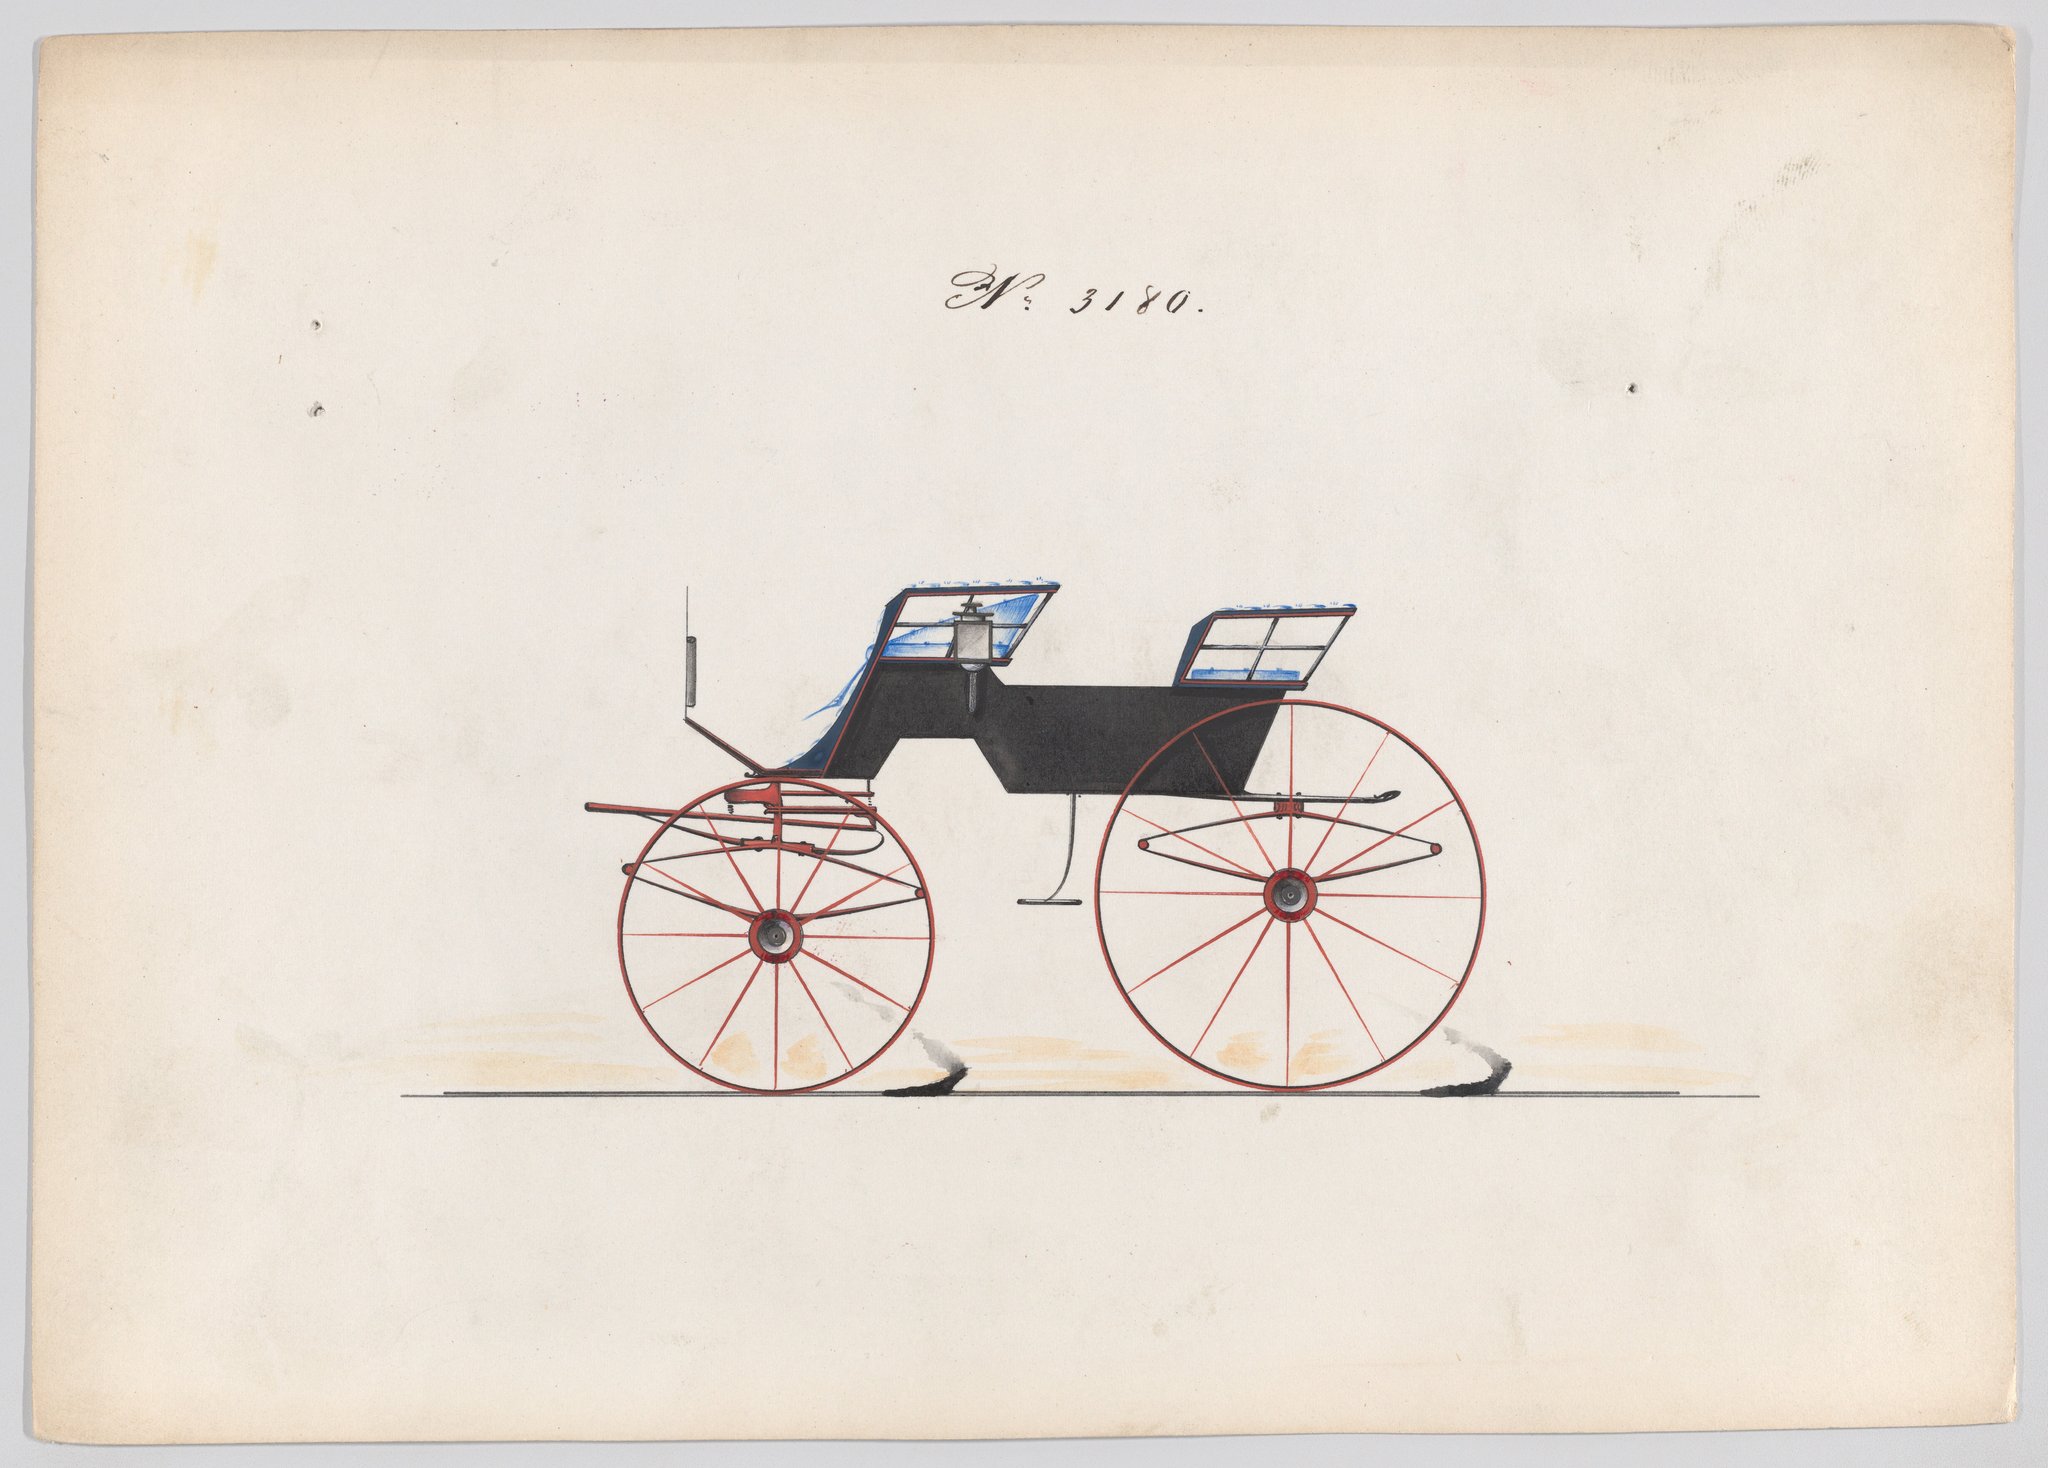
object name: drawing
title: Design for T-Cart, no. 3180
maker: brewster & co.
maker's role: manufacturer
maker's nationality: american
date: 1876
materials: gum arabic, ink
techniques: pen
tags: carriages